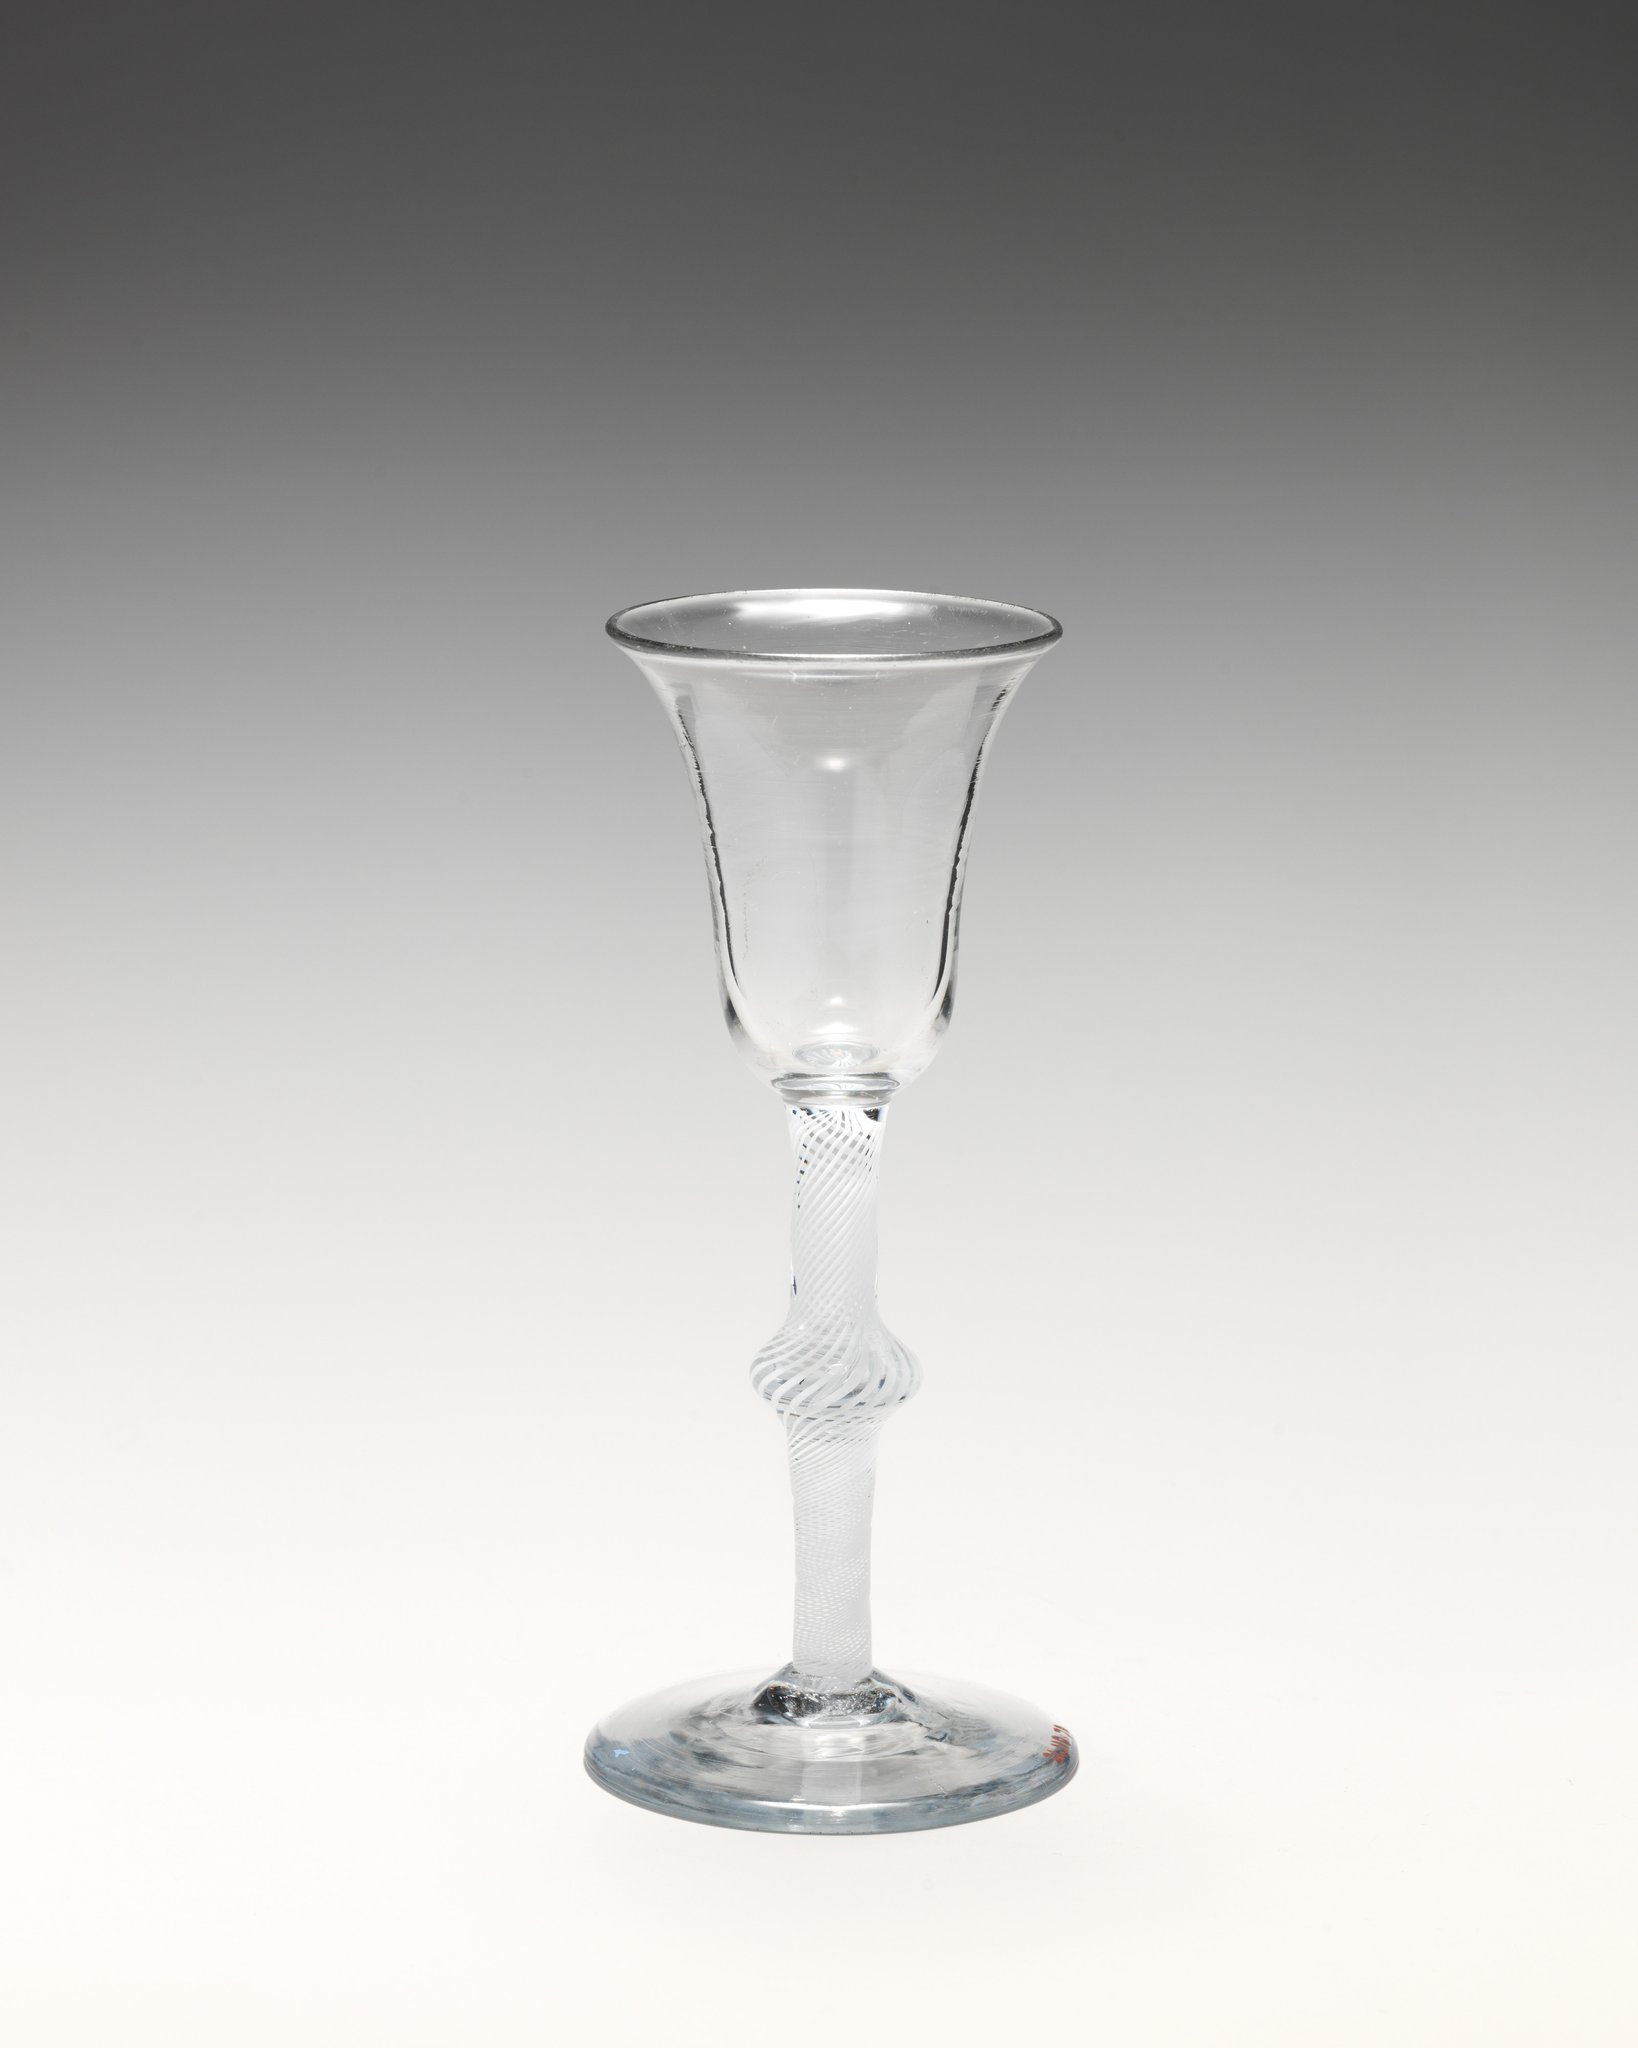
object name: wineglass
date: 1750-1800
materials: glass